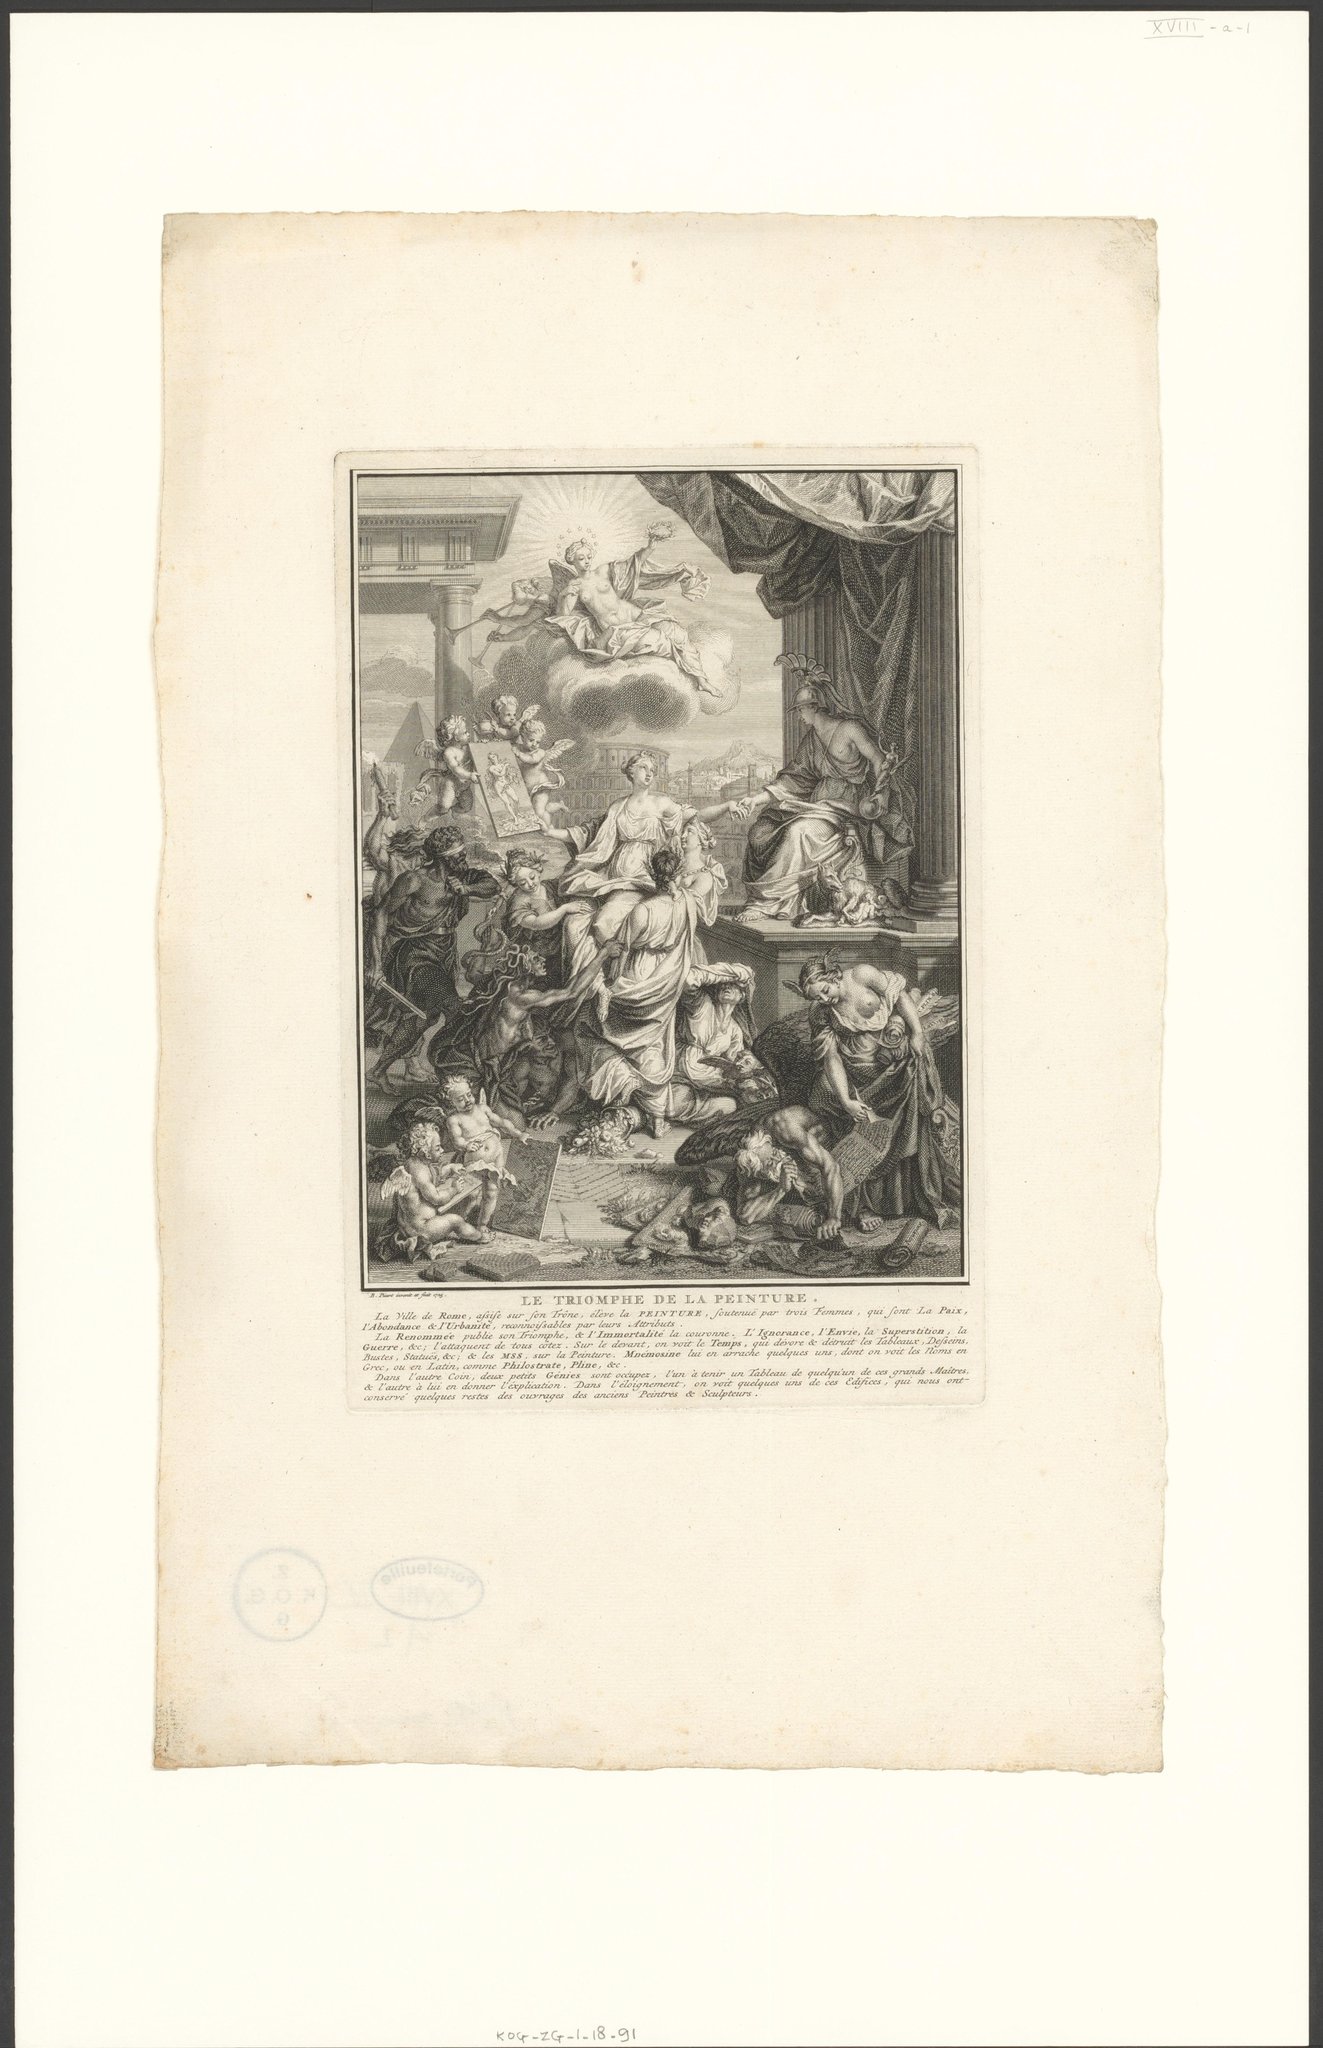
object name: titelblad, titelpagina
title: Le Triomphe de la Peinture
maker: bernard picart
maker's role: draughtsman, print maker, publisher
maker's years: 1673-1733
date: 1725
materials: paper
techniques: engraving, etching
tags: mnemosyne, 'pictura', symbolic representations, allegories and emblems ~ painting; 'pittura' (ripa), symbols, allegories of peace, 'pax'; 'pace' (ripa), personification of a city, town-patron(ess), triumphs (allegorical and symbolic), eternity, 'aeternitas'; 'eternità','eternità o perpetuità' (ripa), abundance; 'abondanza', 'abondanza maritima' (ripa), father time, man with wings and scythe, rome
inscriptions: stamp, collector's mark: Lugt 1641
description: Titelpagina voor: Plinius. Histoire de la peinture ancienne, extraite de l'Hist. Naturelle : avec le texte latin ... éclairci par des remarques nouvelles. [Vertaald door] David Durand. Londen: Guillaume Bowyer, 1725.